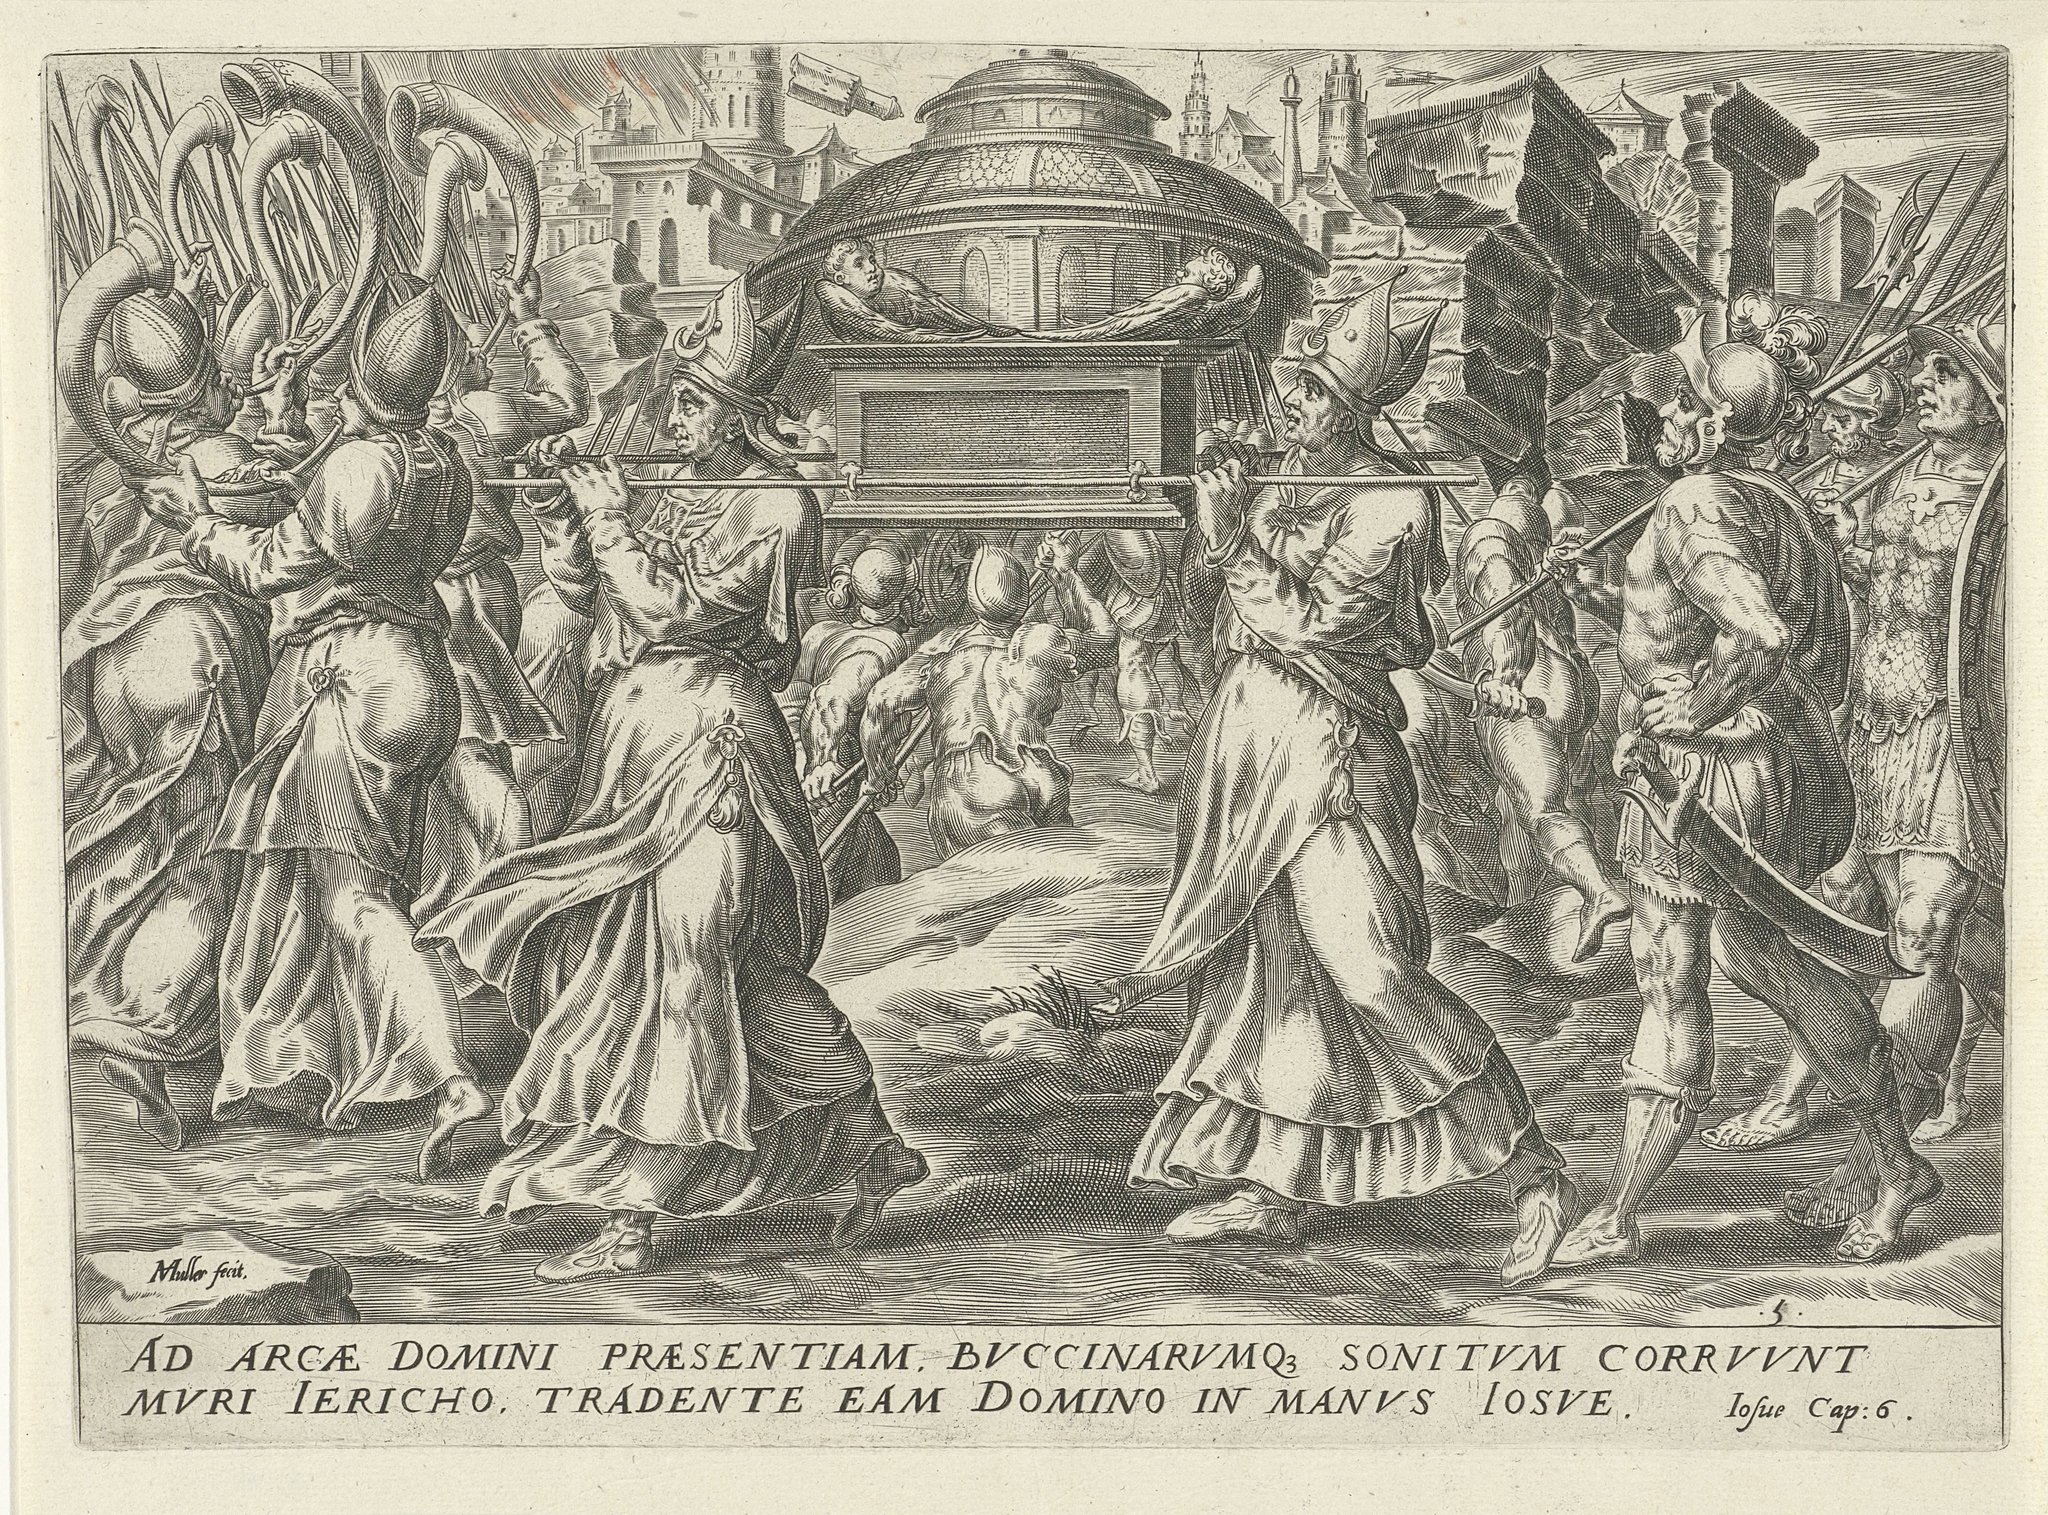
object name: print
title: De geschiedenis van Jozua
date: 1567-1570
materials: paper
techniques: engraving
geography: amsterdam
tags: on the seventh day, at a signal from joshua, the people start to shout and the walls of jericho crumble, the israelites march around jericho: in the procession the main body of the soldiers comes first, next are seven priests who blow on trumpets, followed by the priests carrying the ark and a rear guard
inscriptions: collector's mark: Lugt 2228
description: Zeven priesters blazen op hun ramshorens, terwijl ze voor de ark van het verbond uit lopen. De muren van de stad Jericho storten in en het volk bestormt de stad. Onderaan in de marge een verwijzing naar de Bijbeltekst in het Latijn.